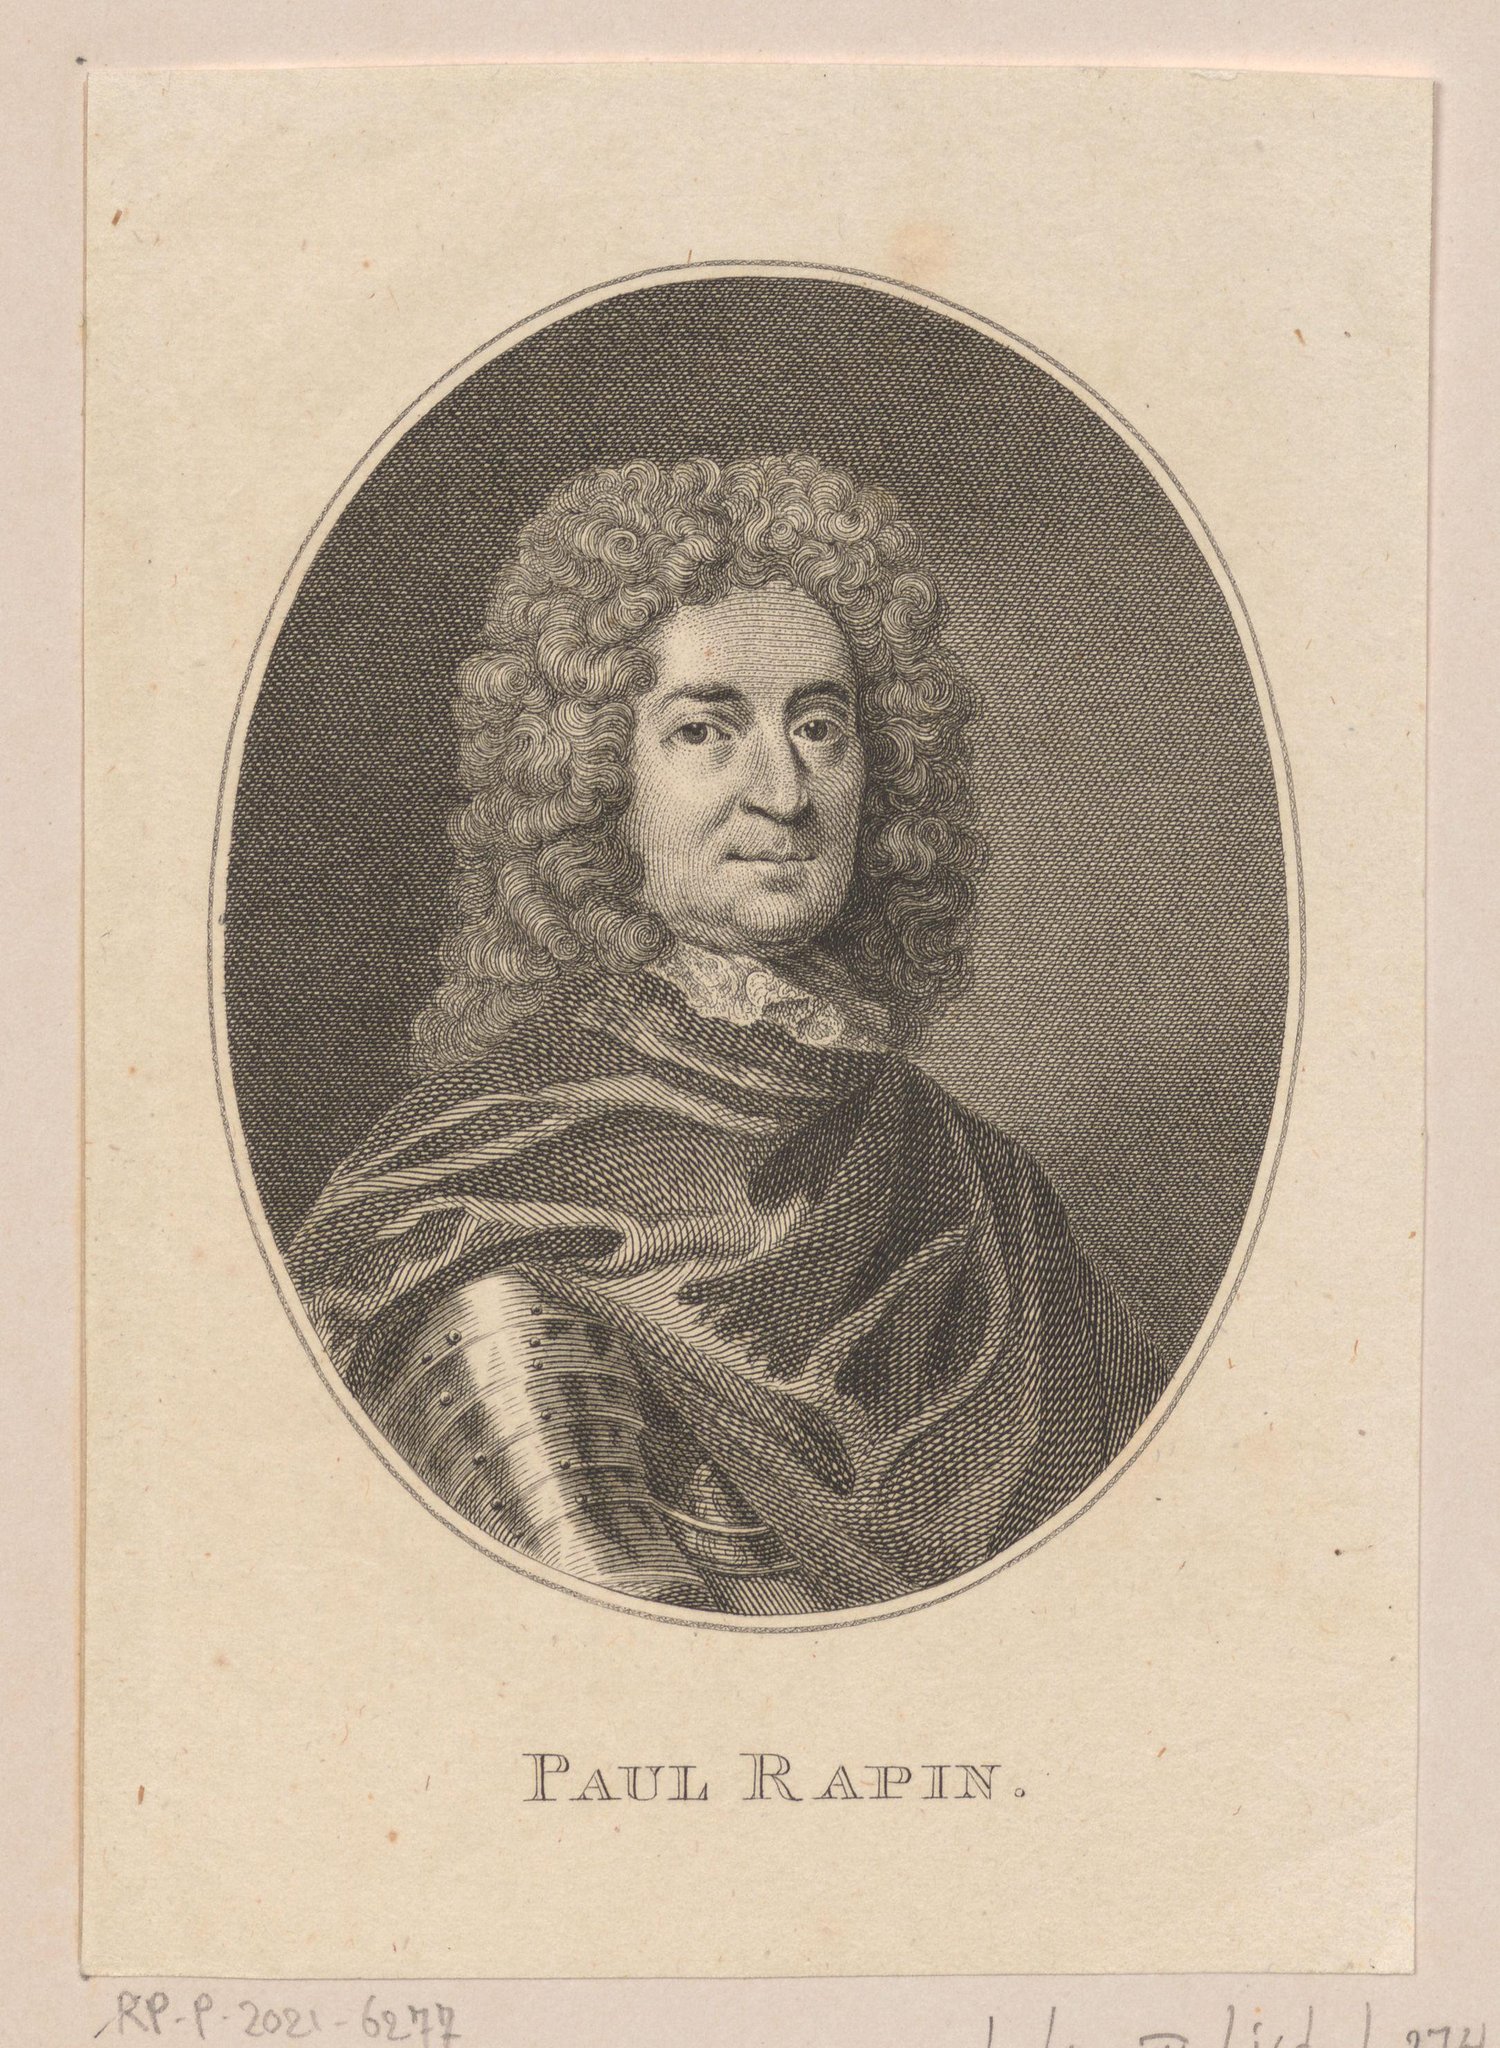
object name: print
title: Portret van Paul de Rapin de Thoyras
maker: Anonymous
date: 1691-1749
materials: paper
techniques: engraving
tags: harness, historical persons